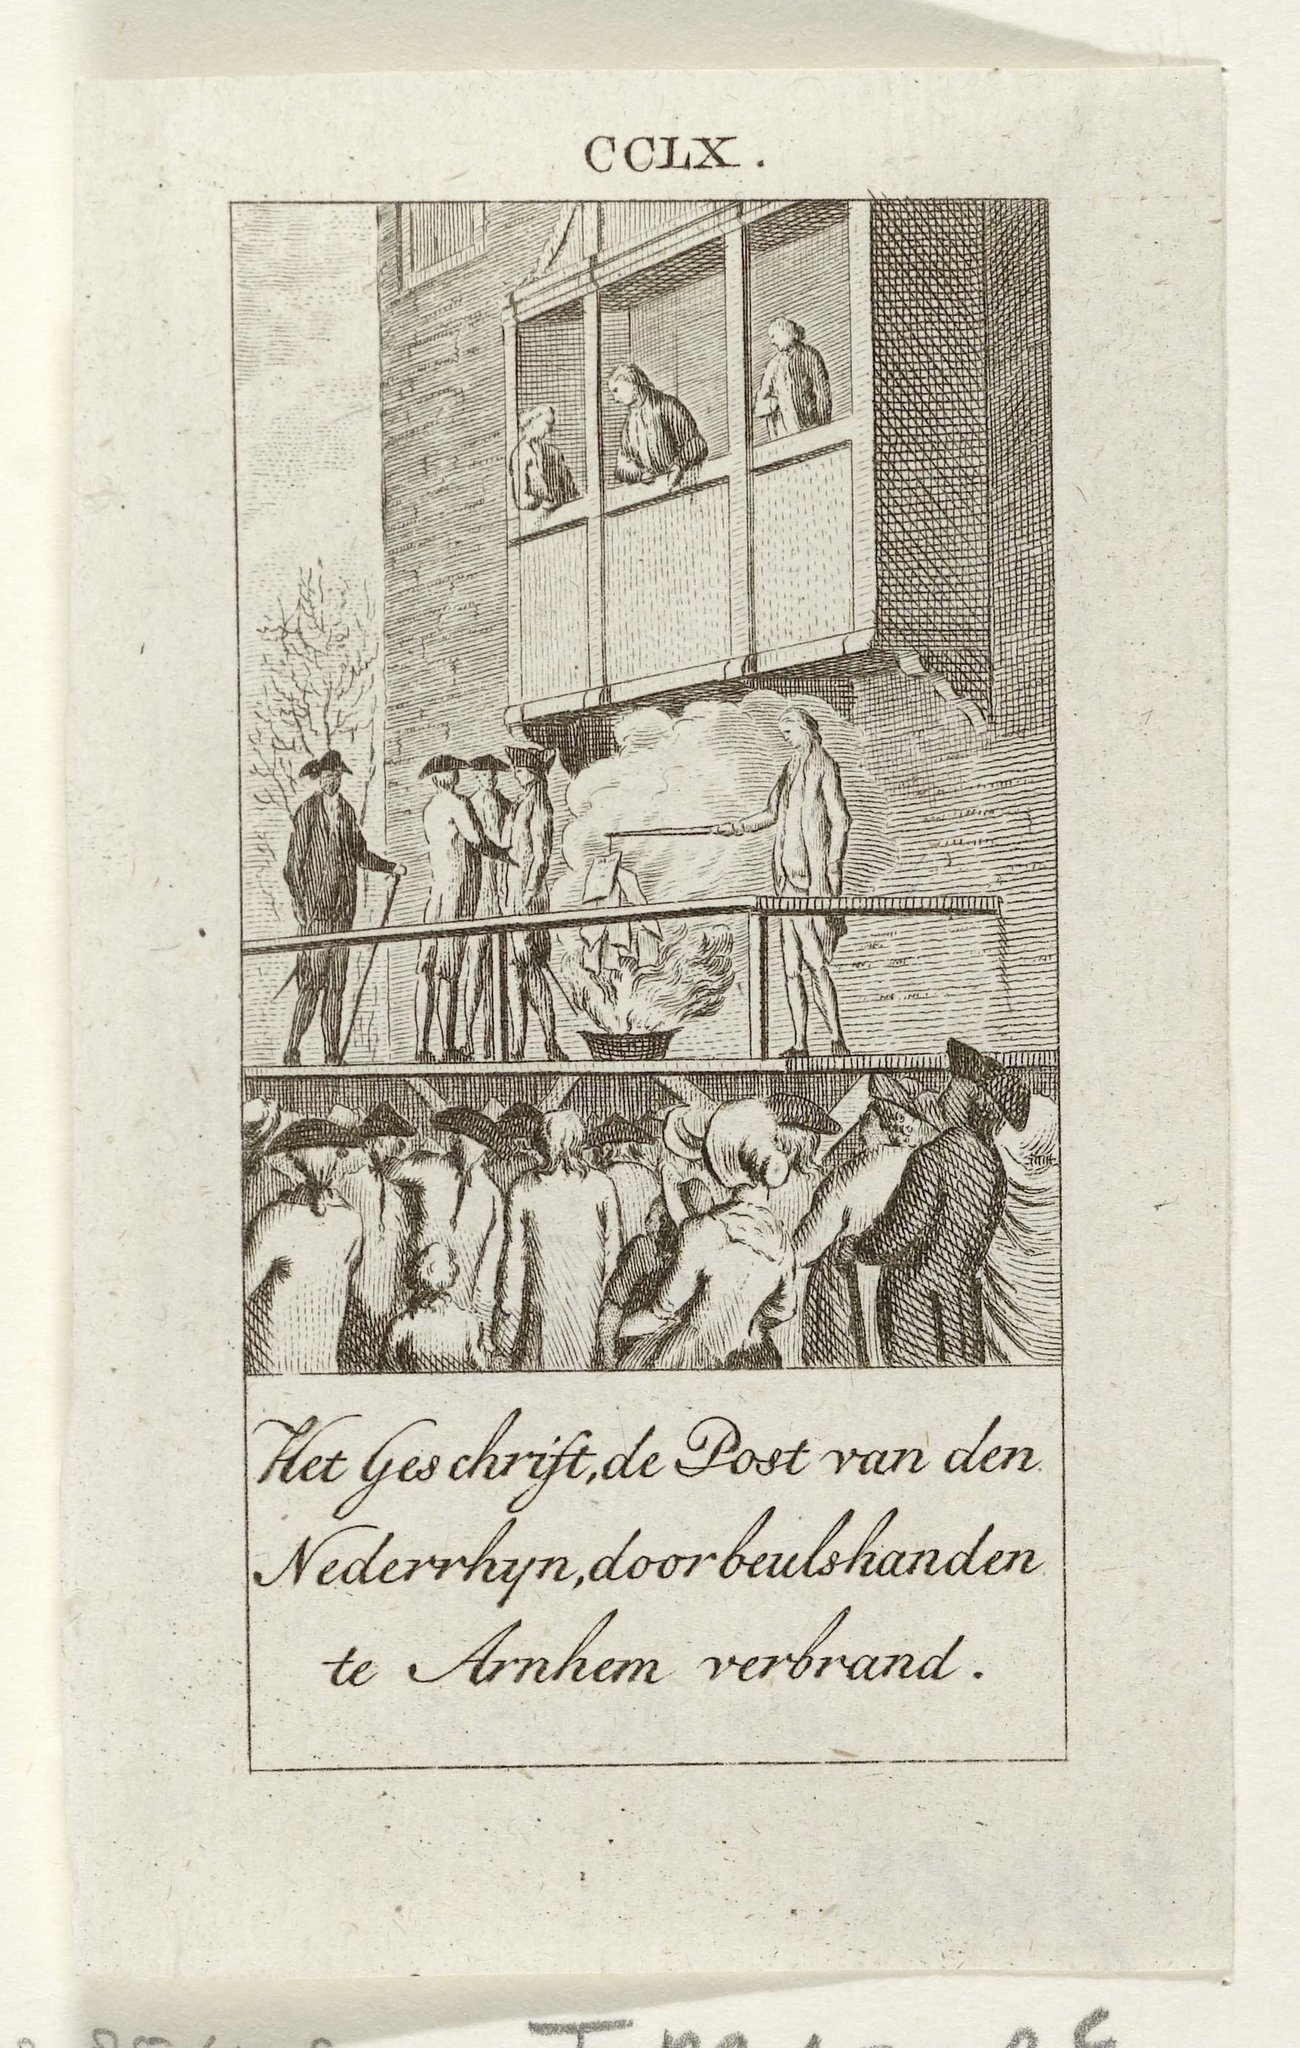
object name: print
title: Het Geschrift, de Post van den Nederrhyn, door beulshanden te Arnhem verbrand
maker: Anonymous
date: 1786-1799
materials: paper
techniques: engraving, etching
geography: northern netherlands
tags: on the scaffold or place of execution, burning of books, arnhem, patriots (1780-1795)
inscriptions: collector's mark: Lugt 2228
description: Openbare executie door verbranding door een beul van een exemplaar van het patriotse tijdschrift De Post van den Neder-Rhijn, op een schavot voor het oude stadhuis van Arnhem, 22 april 1786. Actie door tegenstanders van het blad waarin de vrijlating van de van moord beschuldigde korporaal van Douglas werd veroordeeld. Gemerkt bovenaan: CCLX.